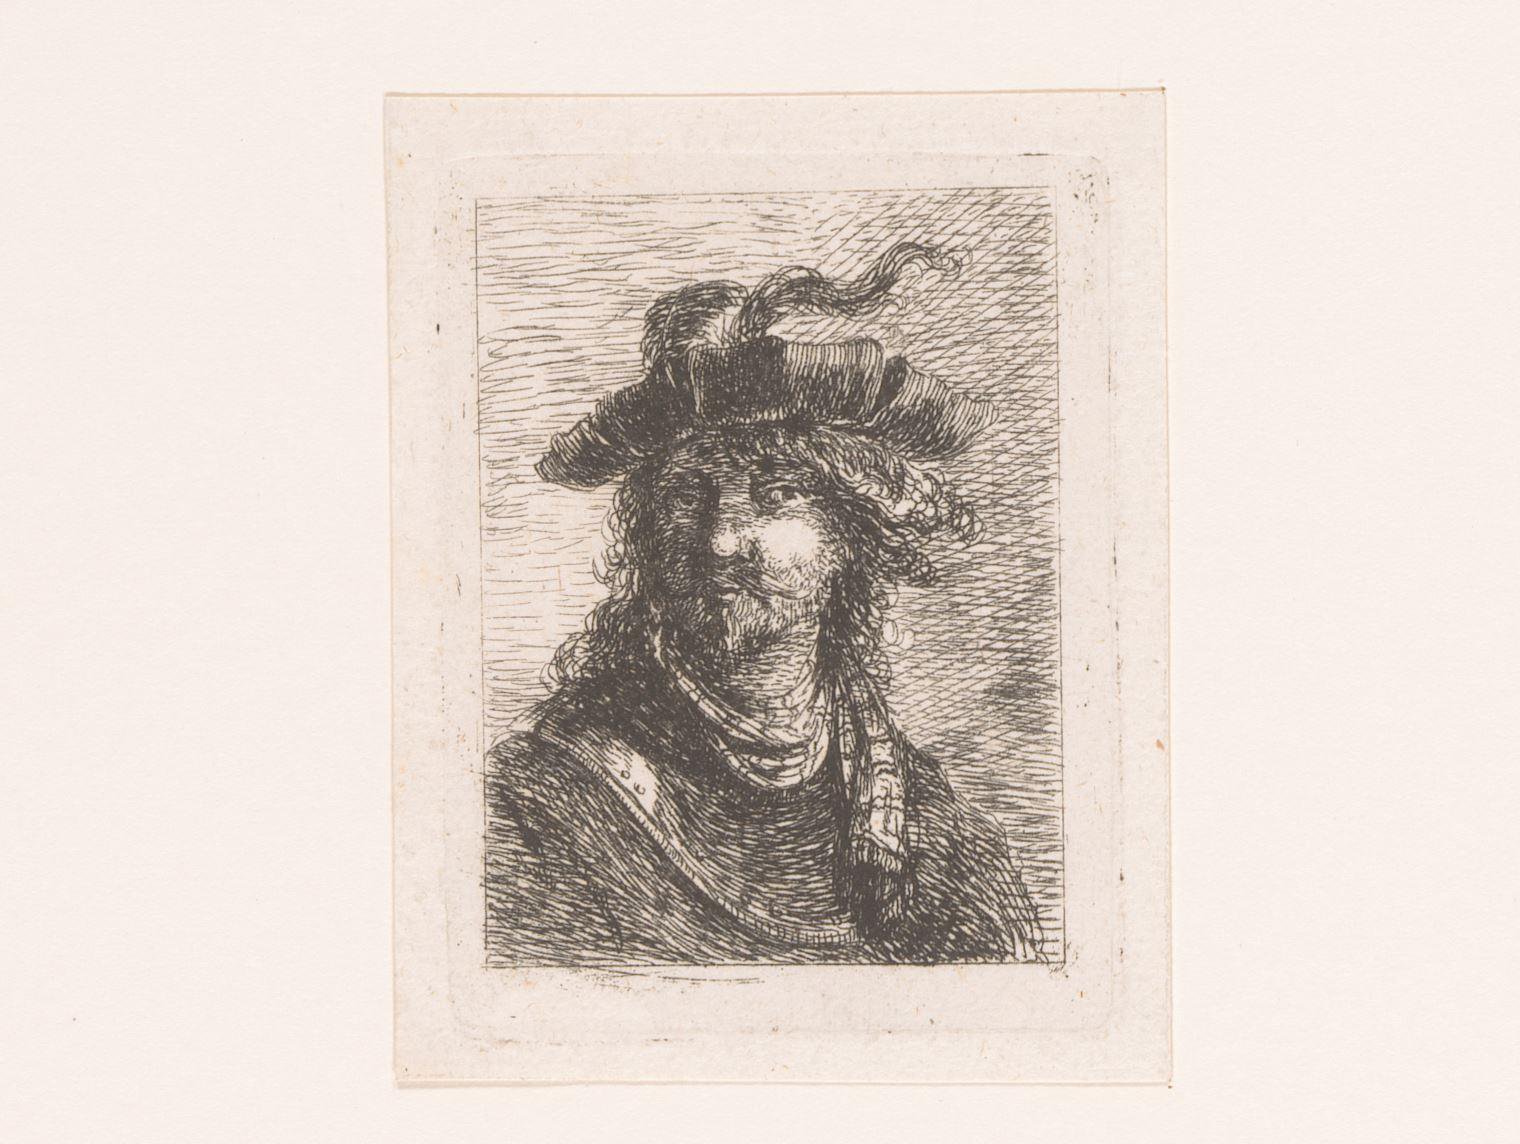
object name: print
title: Kop van man met baret op en shawl om zijn nek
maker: Anonymous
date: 1700-1799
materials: paper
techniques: etching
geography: germany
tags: adult man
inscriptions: collector's mark: Lugt 240